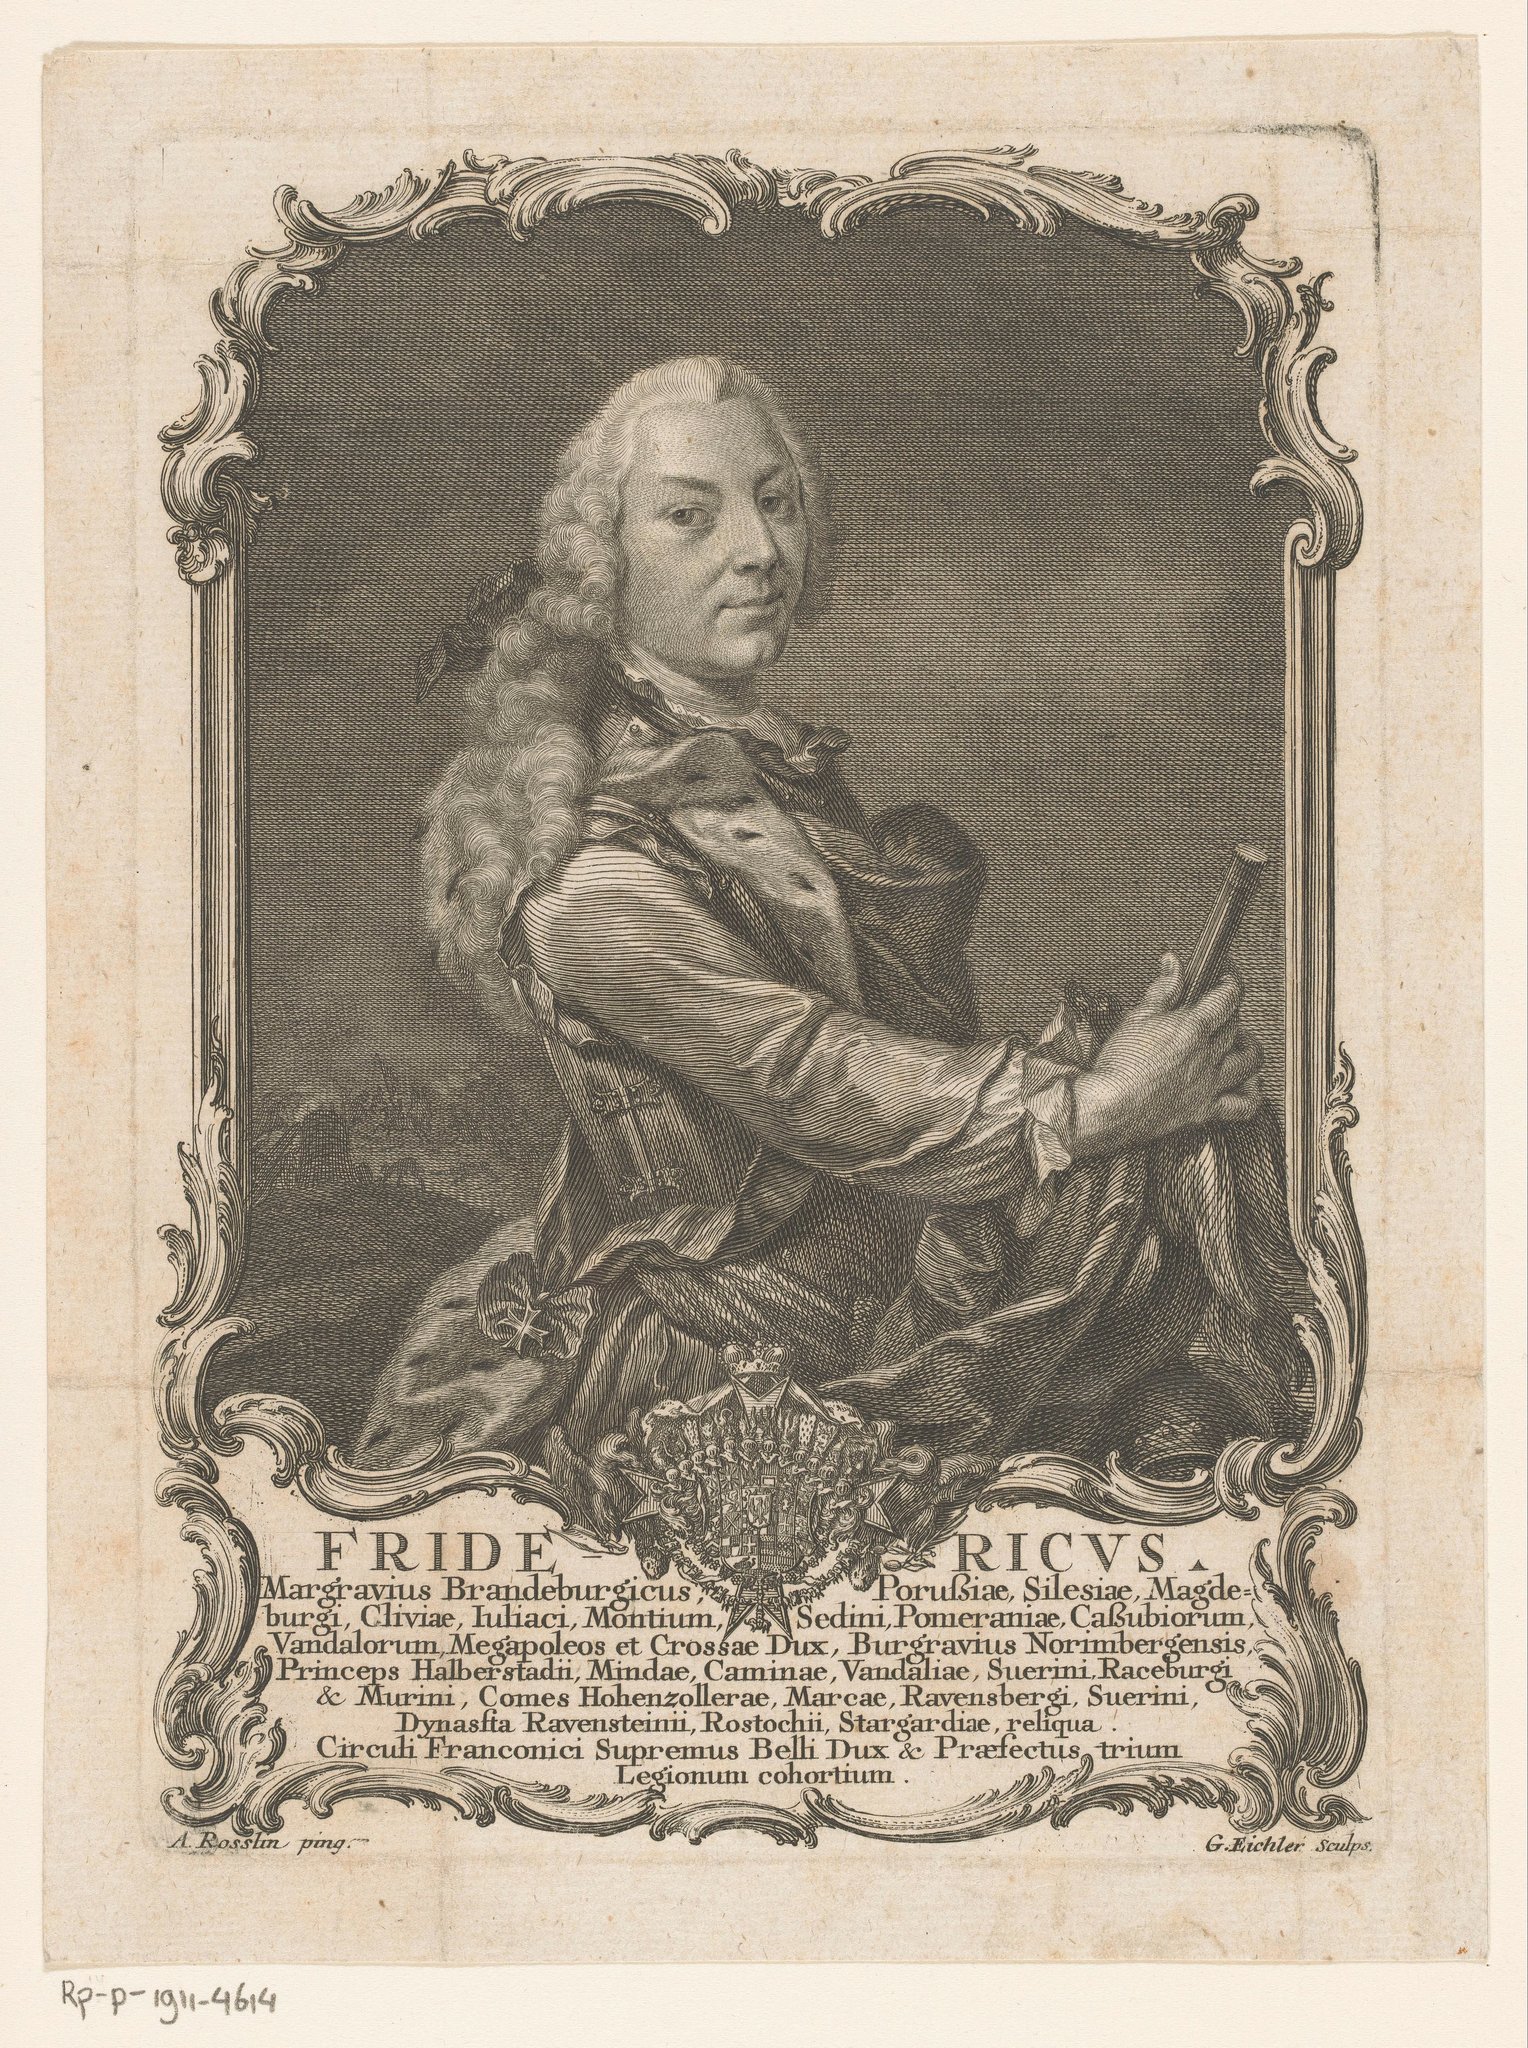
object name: print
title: Portret van Frederik III van Brandenburg-Bayreuth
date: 1758-1818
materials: paper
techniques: engraving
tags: historical persons, baton of general, armorial bearing, heraldry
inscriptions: collector's mark: Lugt 2228